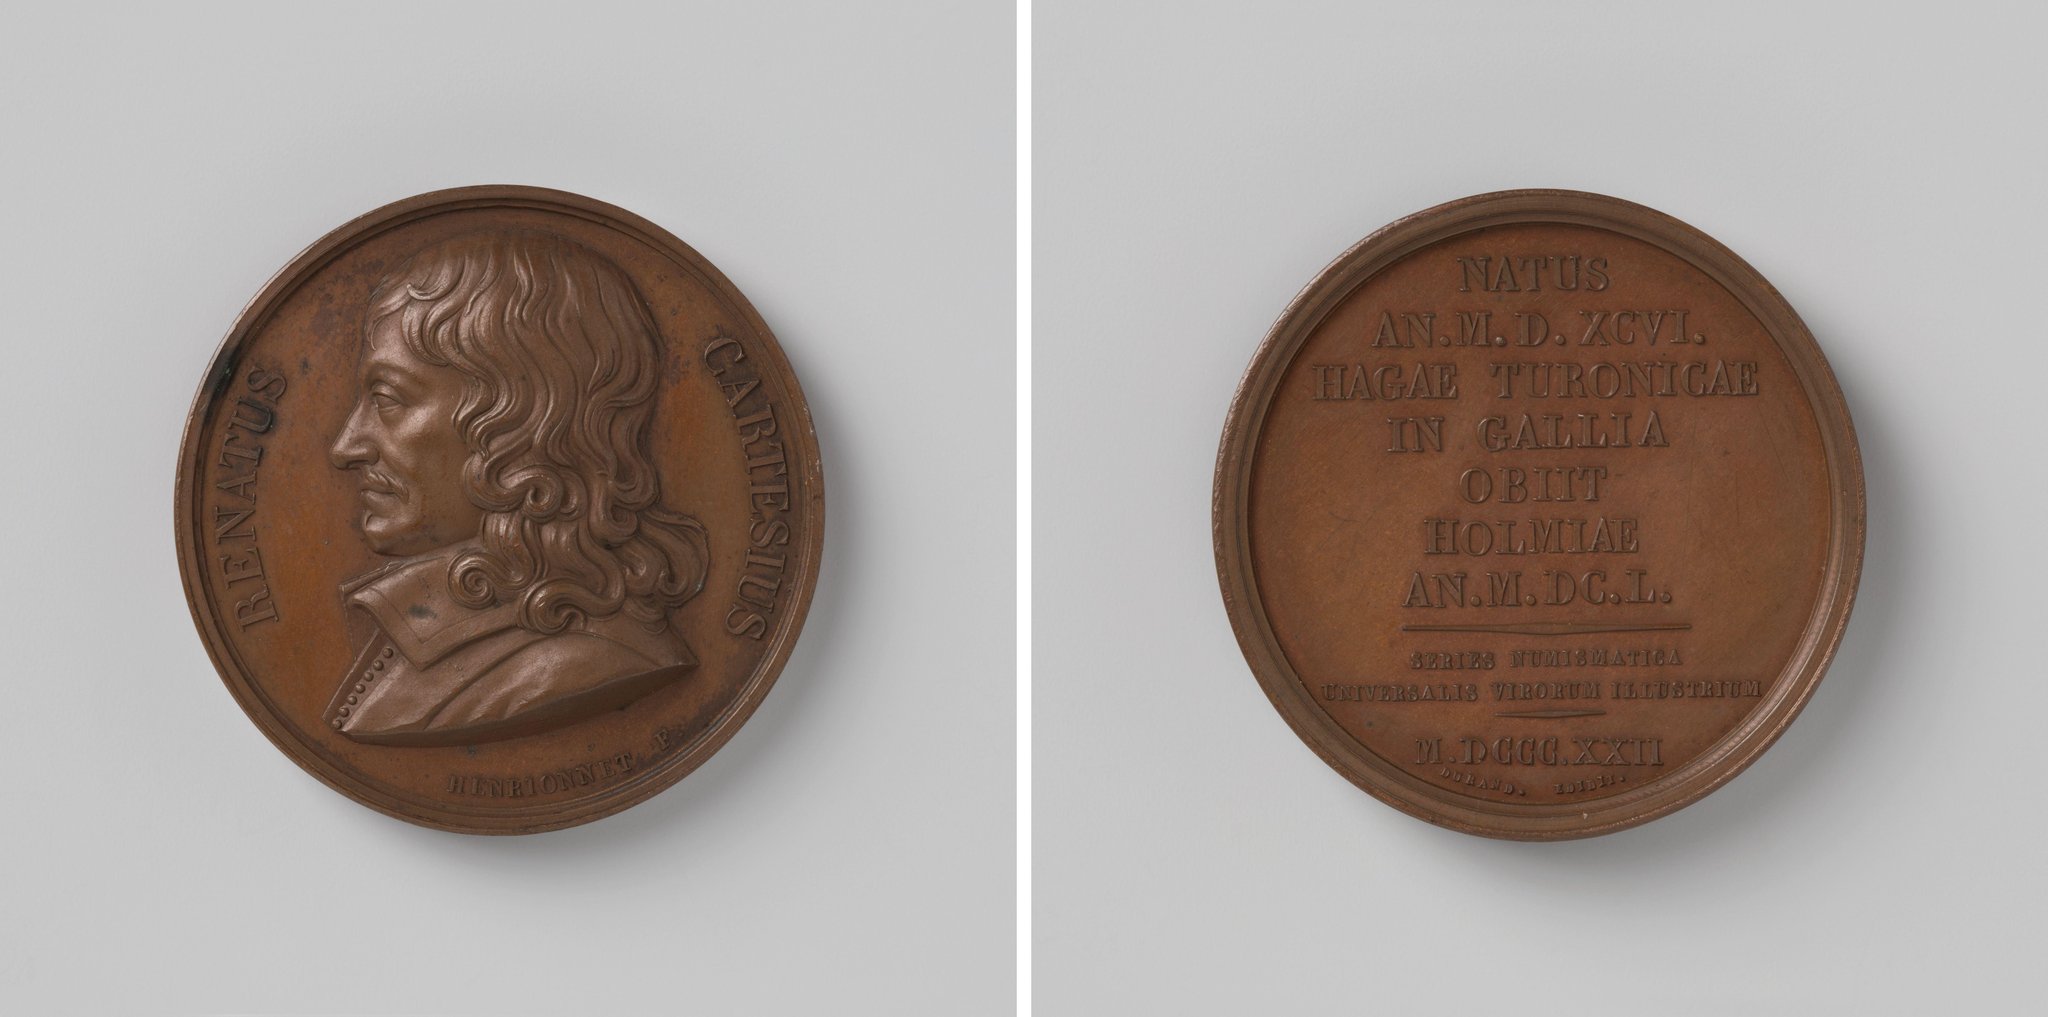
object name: history medal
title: Rene Descartes, beroemd filosoof en wiskundige, onderdeel van de serie Numismatica Universalis Virorum Illustrium door Amédée Durand.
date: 1826-1844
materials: copper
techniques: striking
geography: munich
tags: rené descartes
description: Koperen penning. Voorzijde: borststuk man binnen omschrift. Keerzijde: opschrift; randschrift